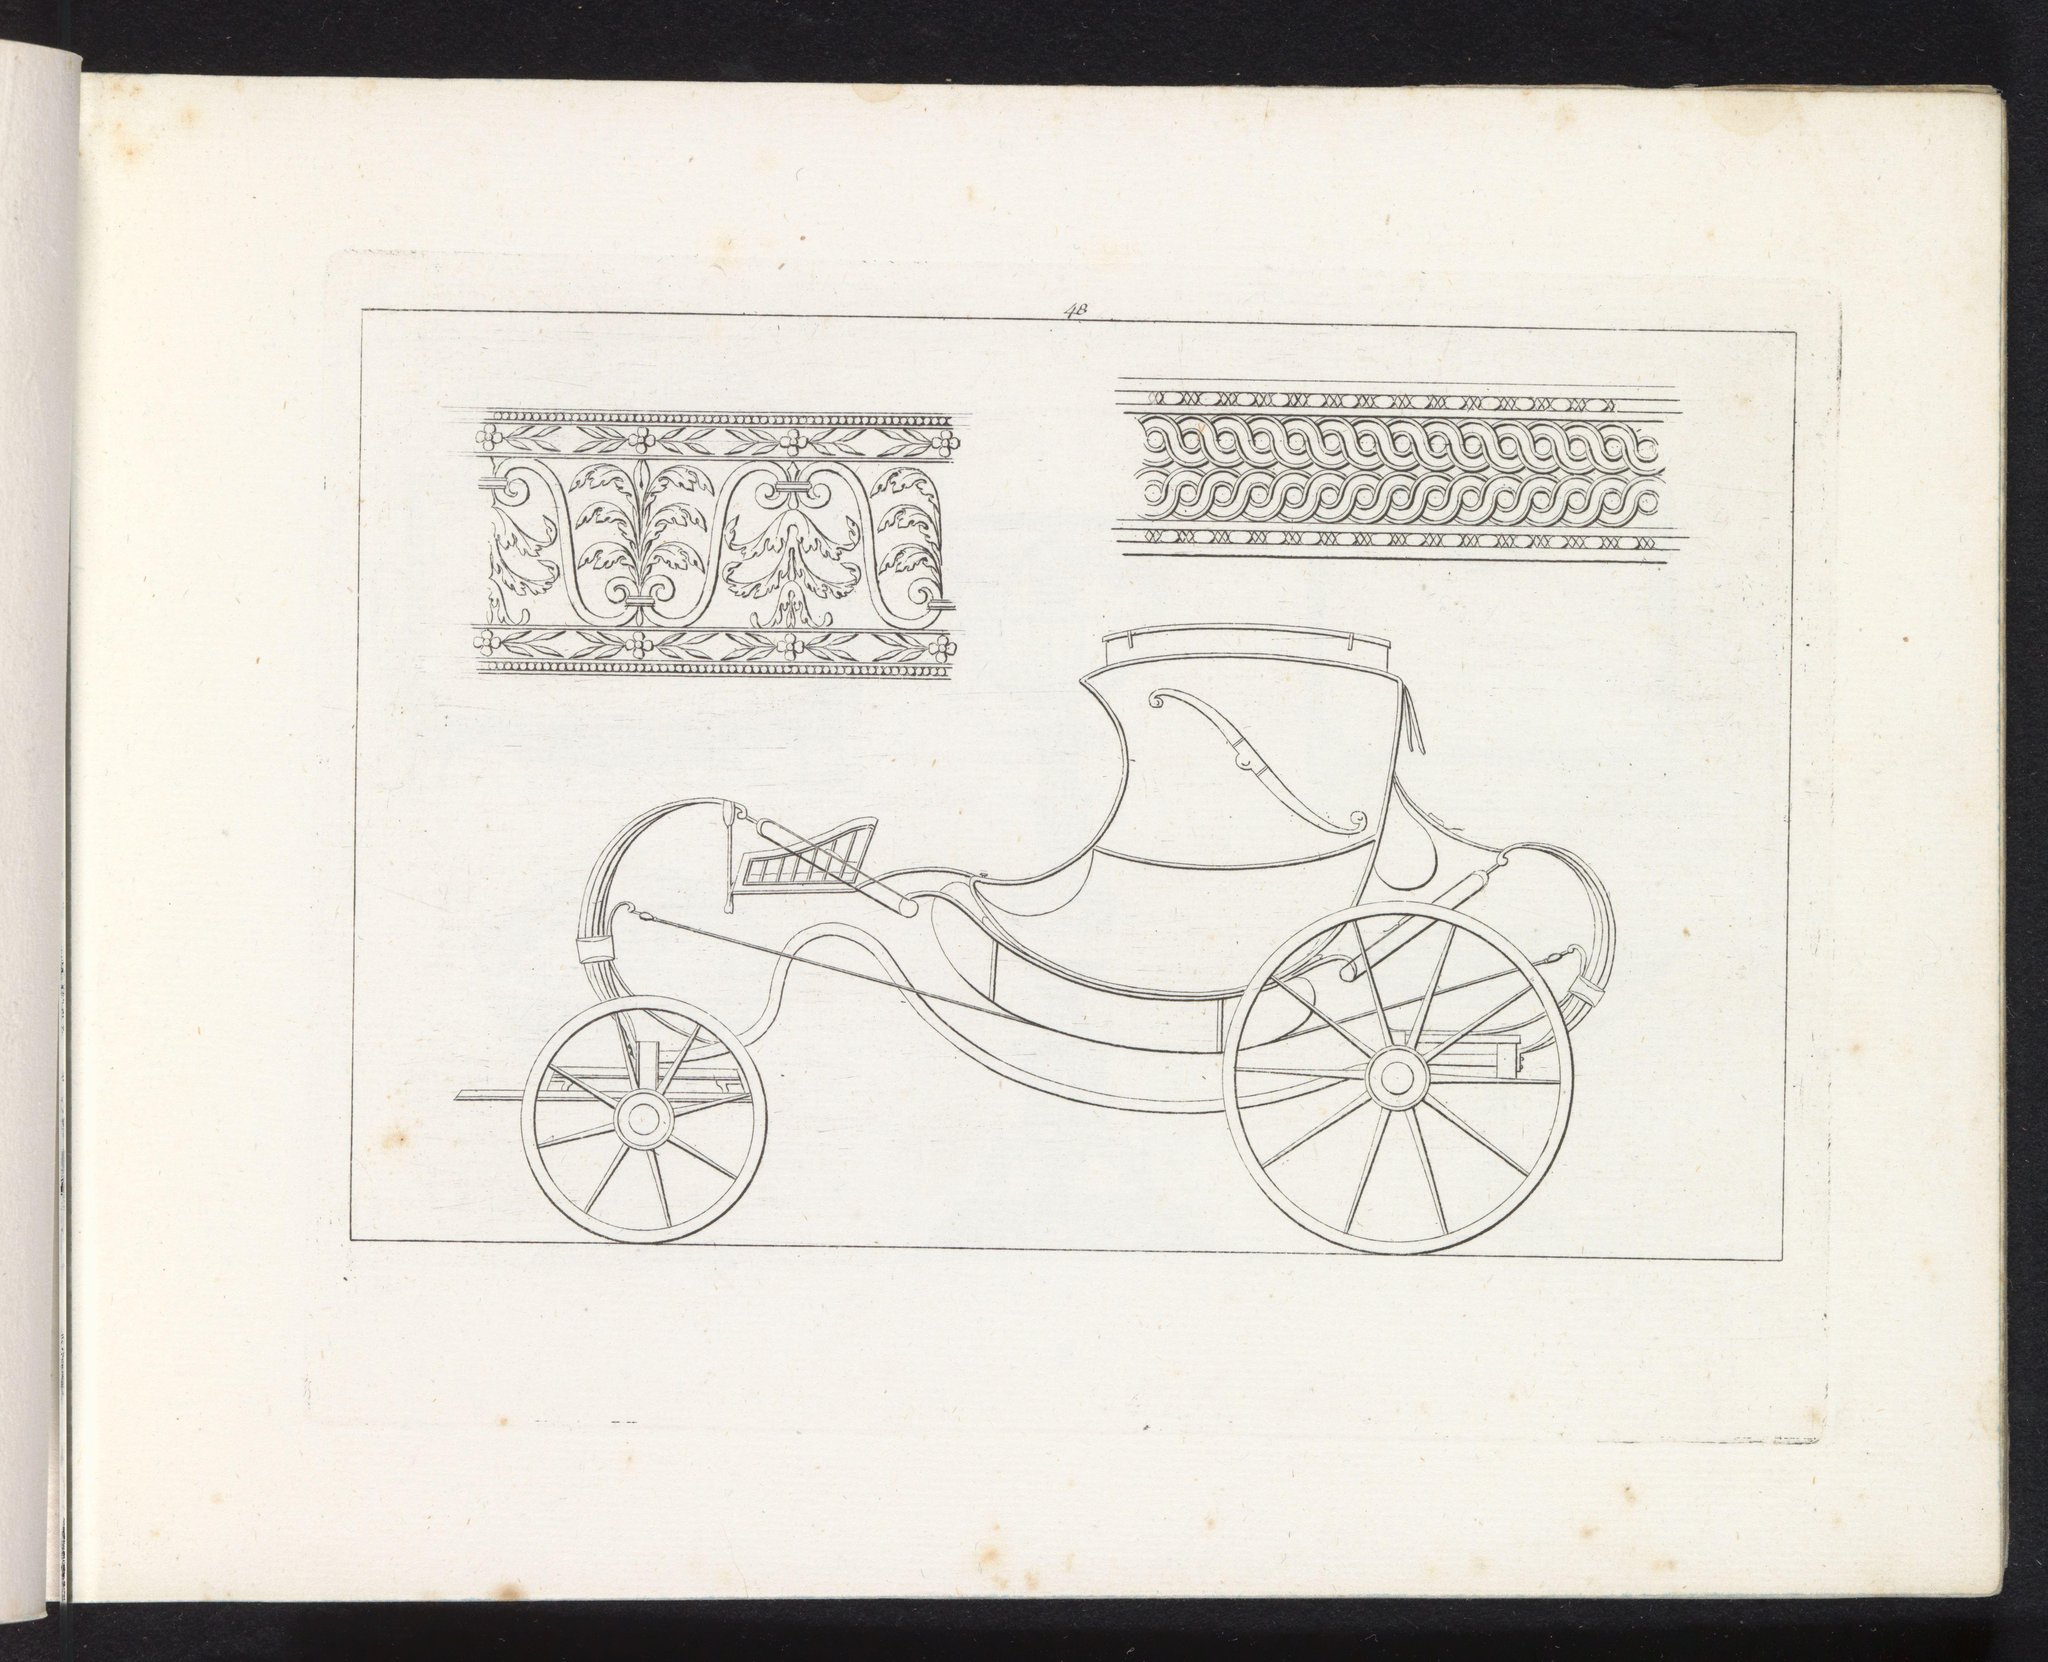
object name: album leaf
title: Twee ornamentele randen en een rijtuig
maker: pietro ruga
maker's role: print maker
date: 1817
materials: paper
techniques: etching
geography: italy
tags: ornaments ~ art, four-wheeled, animal-drawn vehicle, e.g.: cab, carriage, coach, passenger carriage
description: Prent maakt deel uit van een reeks van 100 prenten (+ titelprent) met ontwerpen voor religieuze en profane voorwerpen.